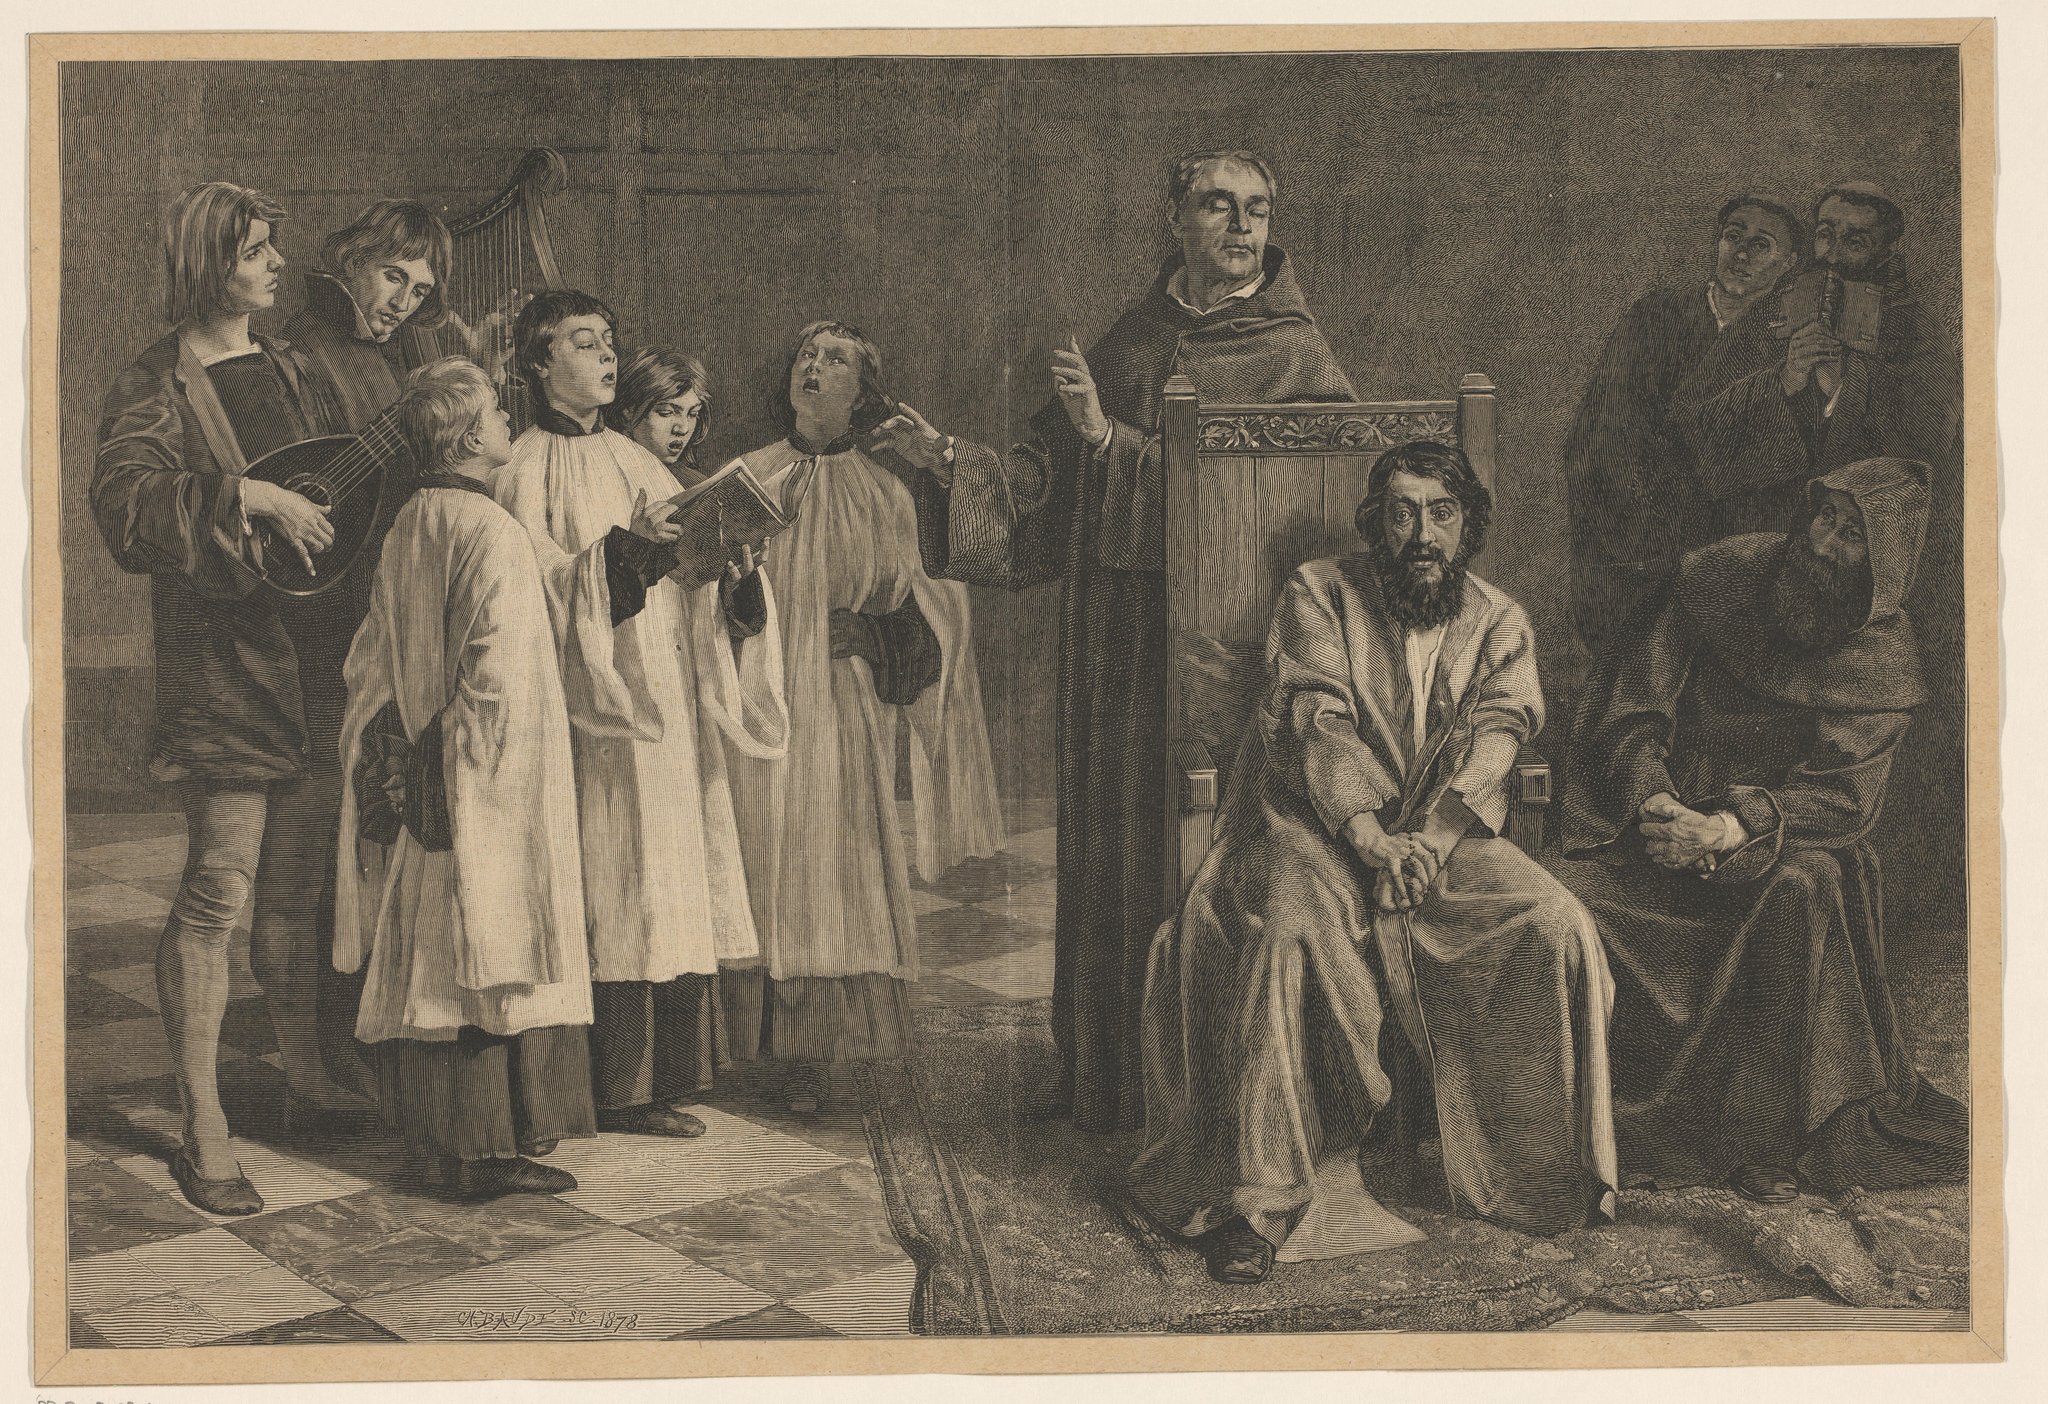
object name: print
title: Hugo van der Goes krijgt muziektherapie in het klooster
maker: charles baude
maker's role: print maker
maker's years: 1853-1935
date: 1878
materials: paper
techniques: engraving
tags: brussels, painter, draughtsman, hugo van der goes, emotional illness, derangement, madness, choir (in church), historical persons, monk(s), friar(s)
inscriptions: date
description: De schilder Hugo van der Goes herstellend van geestesziekte in het Rood Klooster te Oudergem in 1477. Hij werd hier onder meer behandeld met muziektherapie.